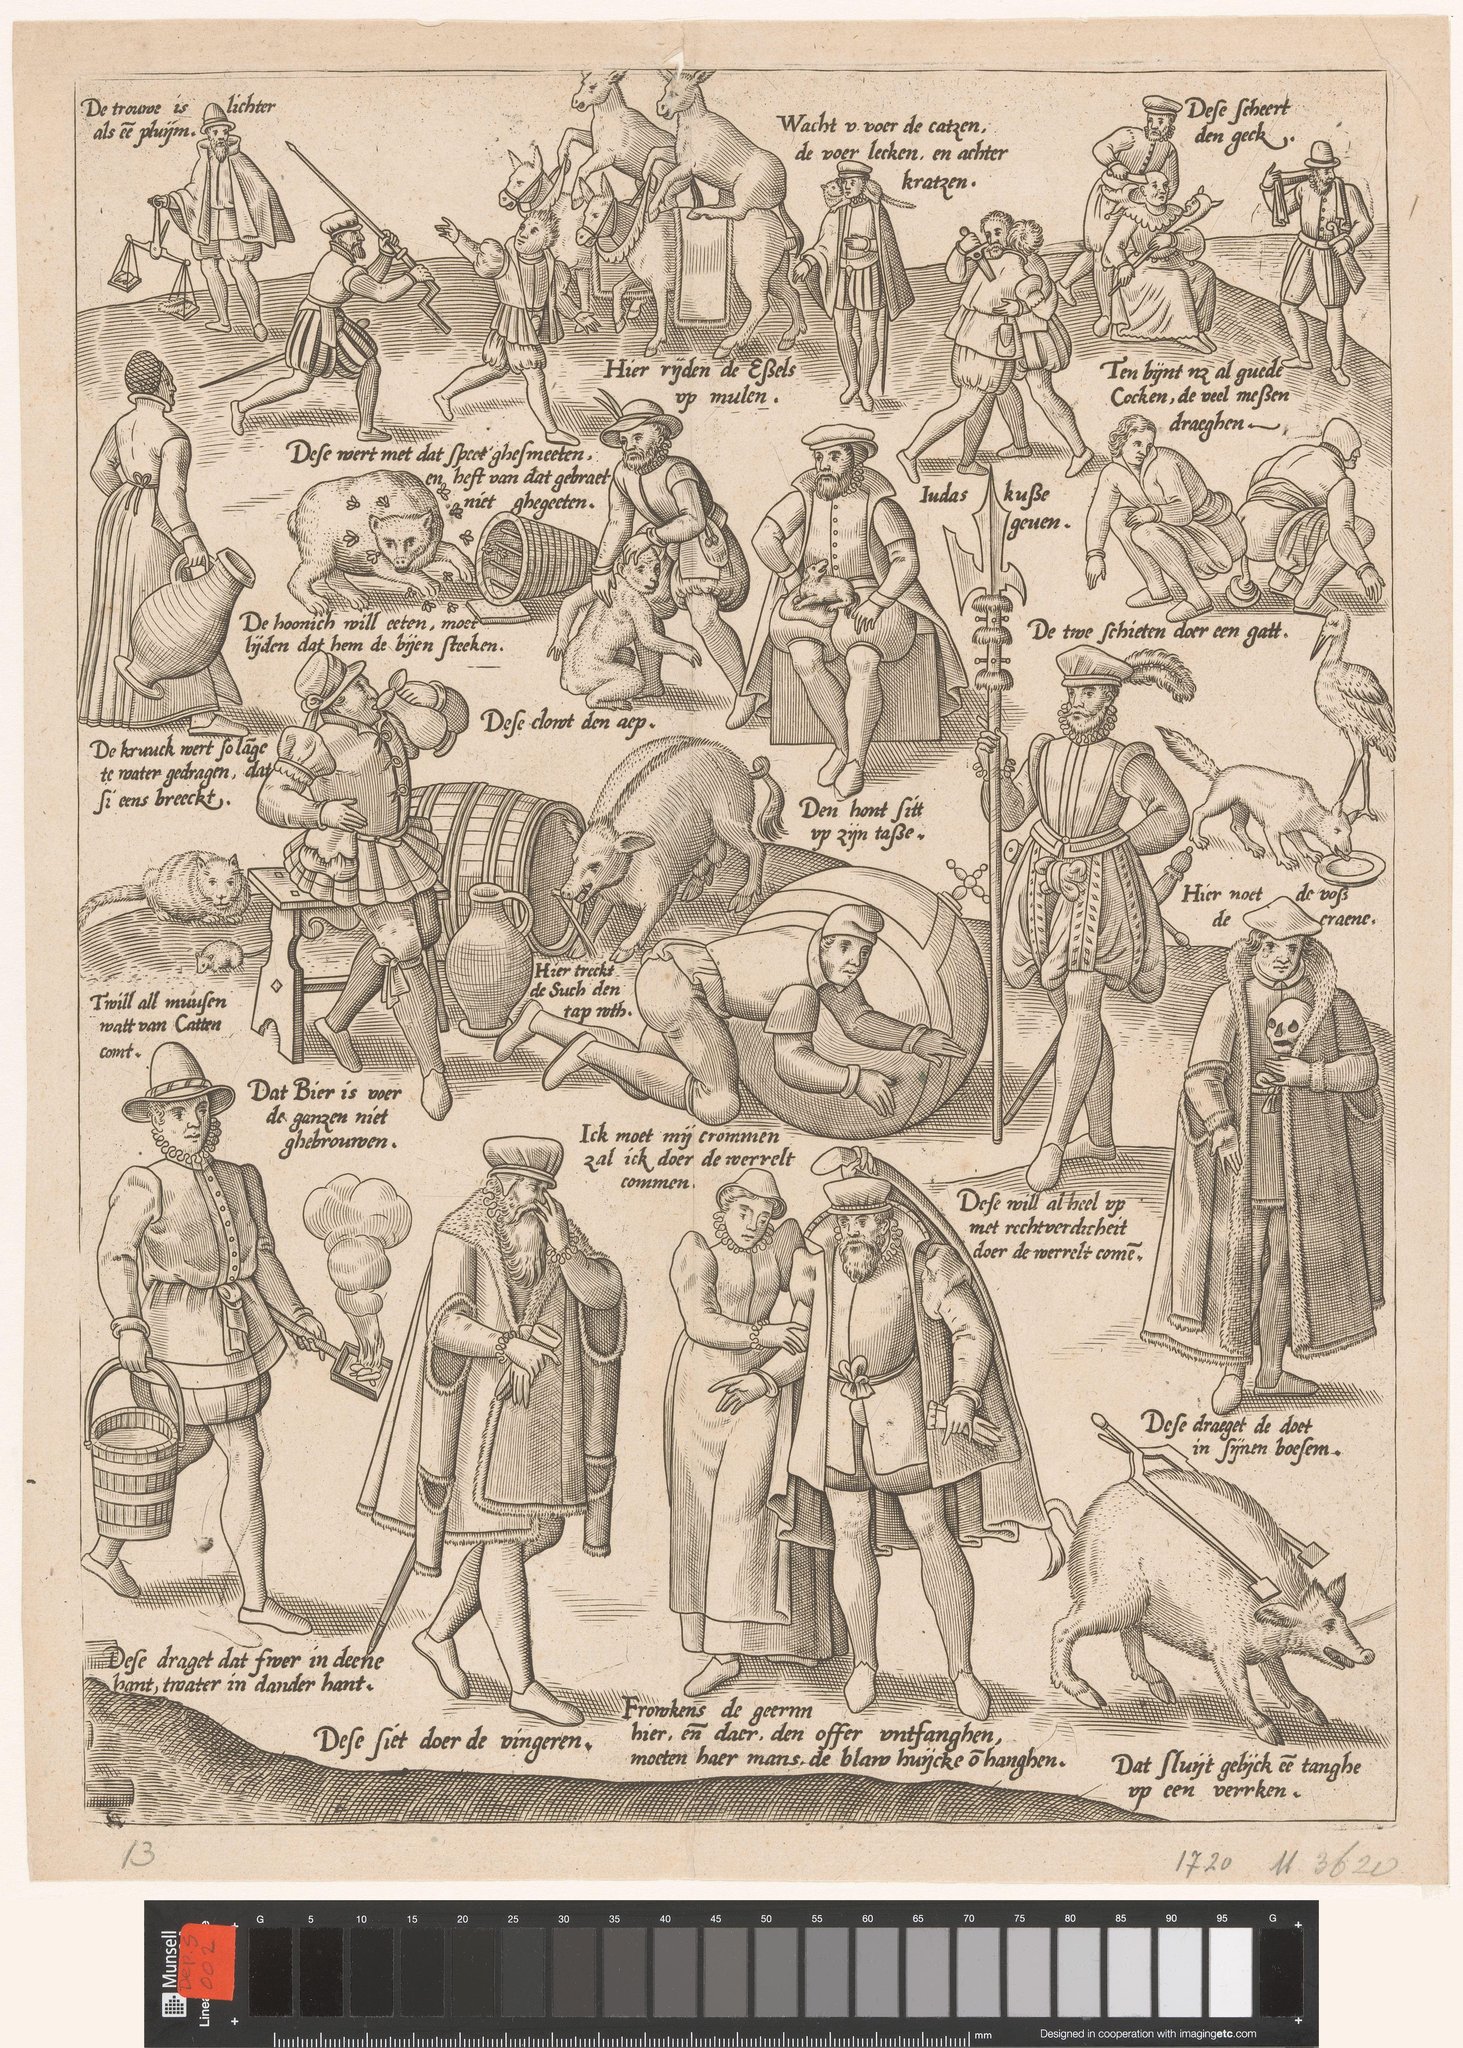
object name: print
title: De Blauwe Huyck (blad 3)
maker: joannes van doetechum (i)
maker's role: print maker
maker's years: 1528-1605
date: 1577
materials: paper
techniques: engraving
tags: proverbs, sayings, etc.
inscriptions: collector's mark: Lugt 2228, number: ‘13’, number: ‘1720 M 3620’, inscription: ‘C. F. M.’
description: Maakt deel uit van een vierdelige geheel met in totaal 88 spreekwoorden, van origine bedoeld als één horizontale fries, getiteld op het eerste blad: 'De Blauwe Huijcke, is dith ghenaemt, maer des Werrelts Idel sprocken, hem beeter betaemt'. Voor de complete reeks zie Rijksmuseum, inv.nr. RP-P-OB-77.683 t/m 686. Zie ook: Gentsche Bijdragen VI, 1939-1940, p. 186.